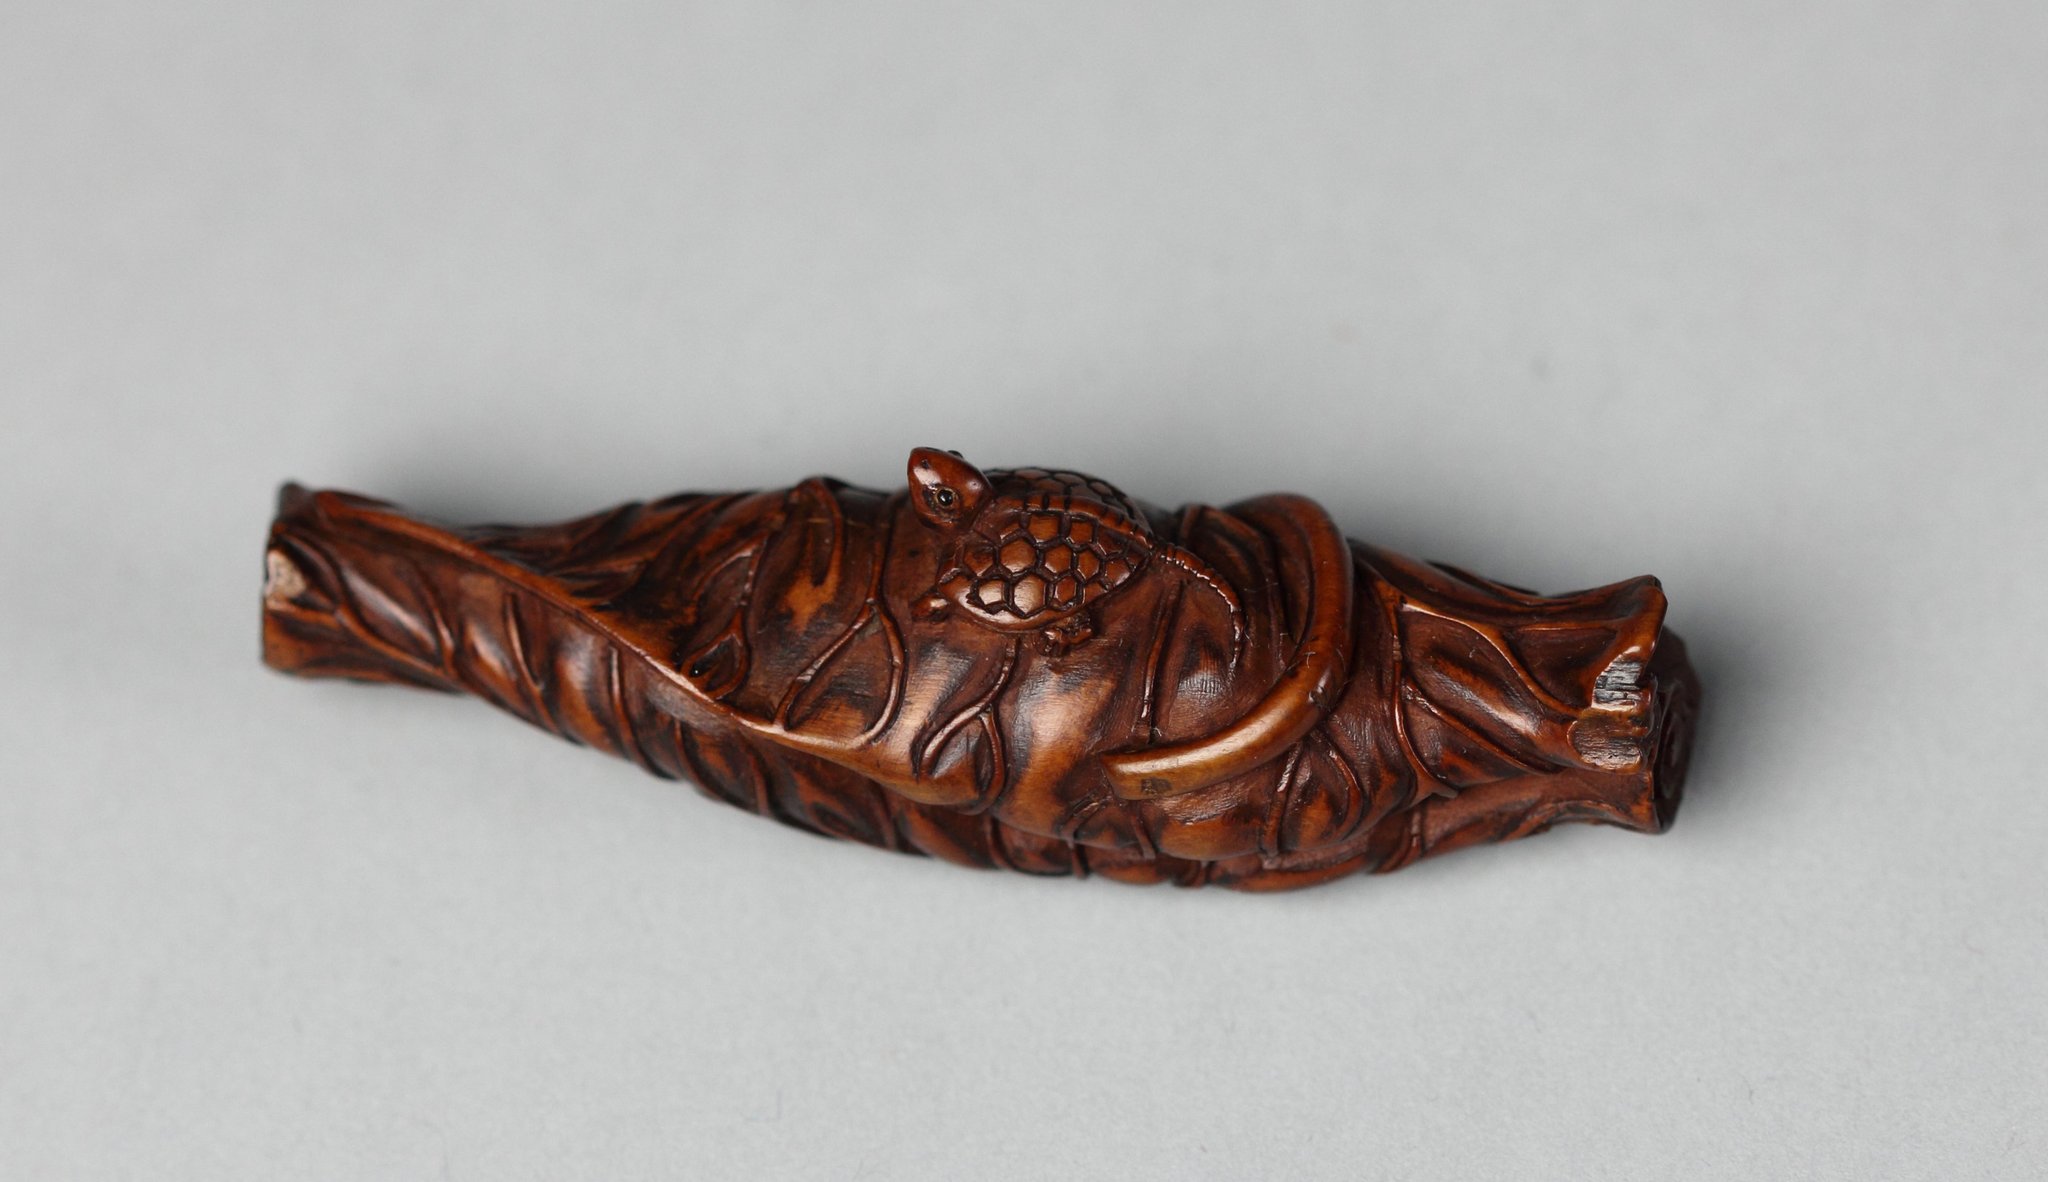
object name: netsuke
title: Lotus Leaf and Small Turtle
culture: japanese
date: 1851-1900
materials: wood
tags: turtles,leaves